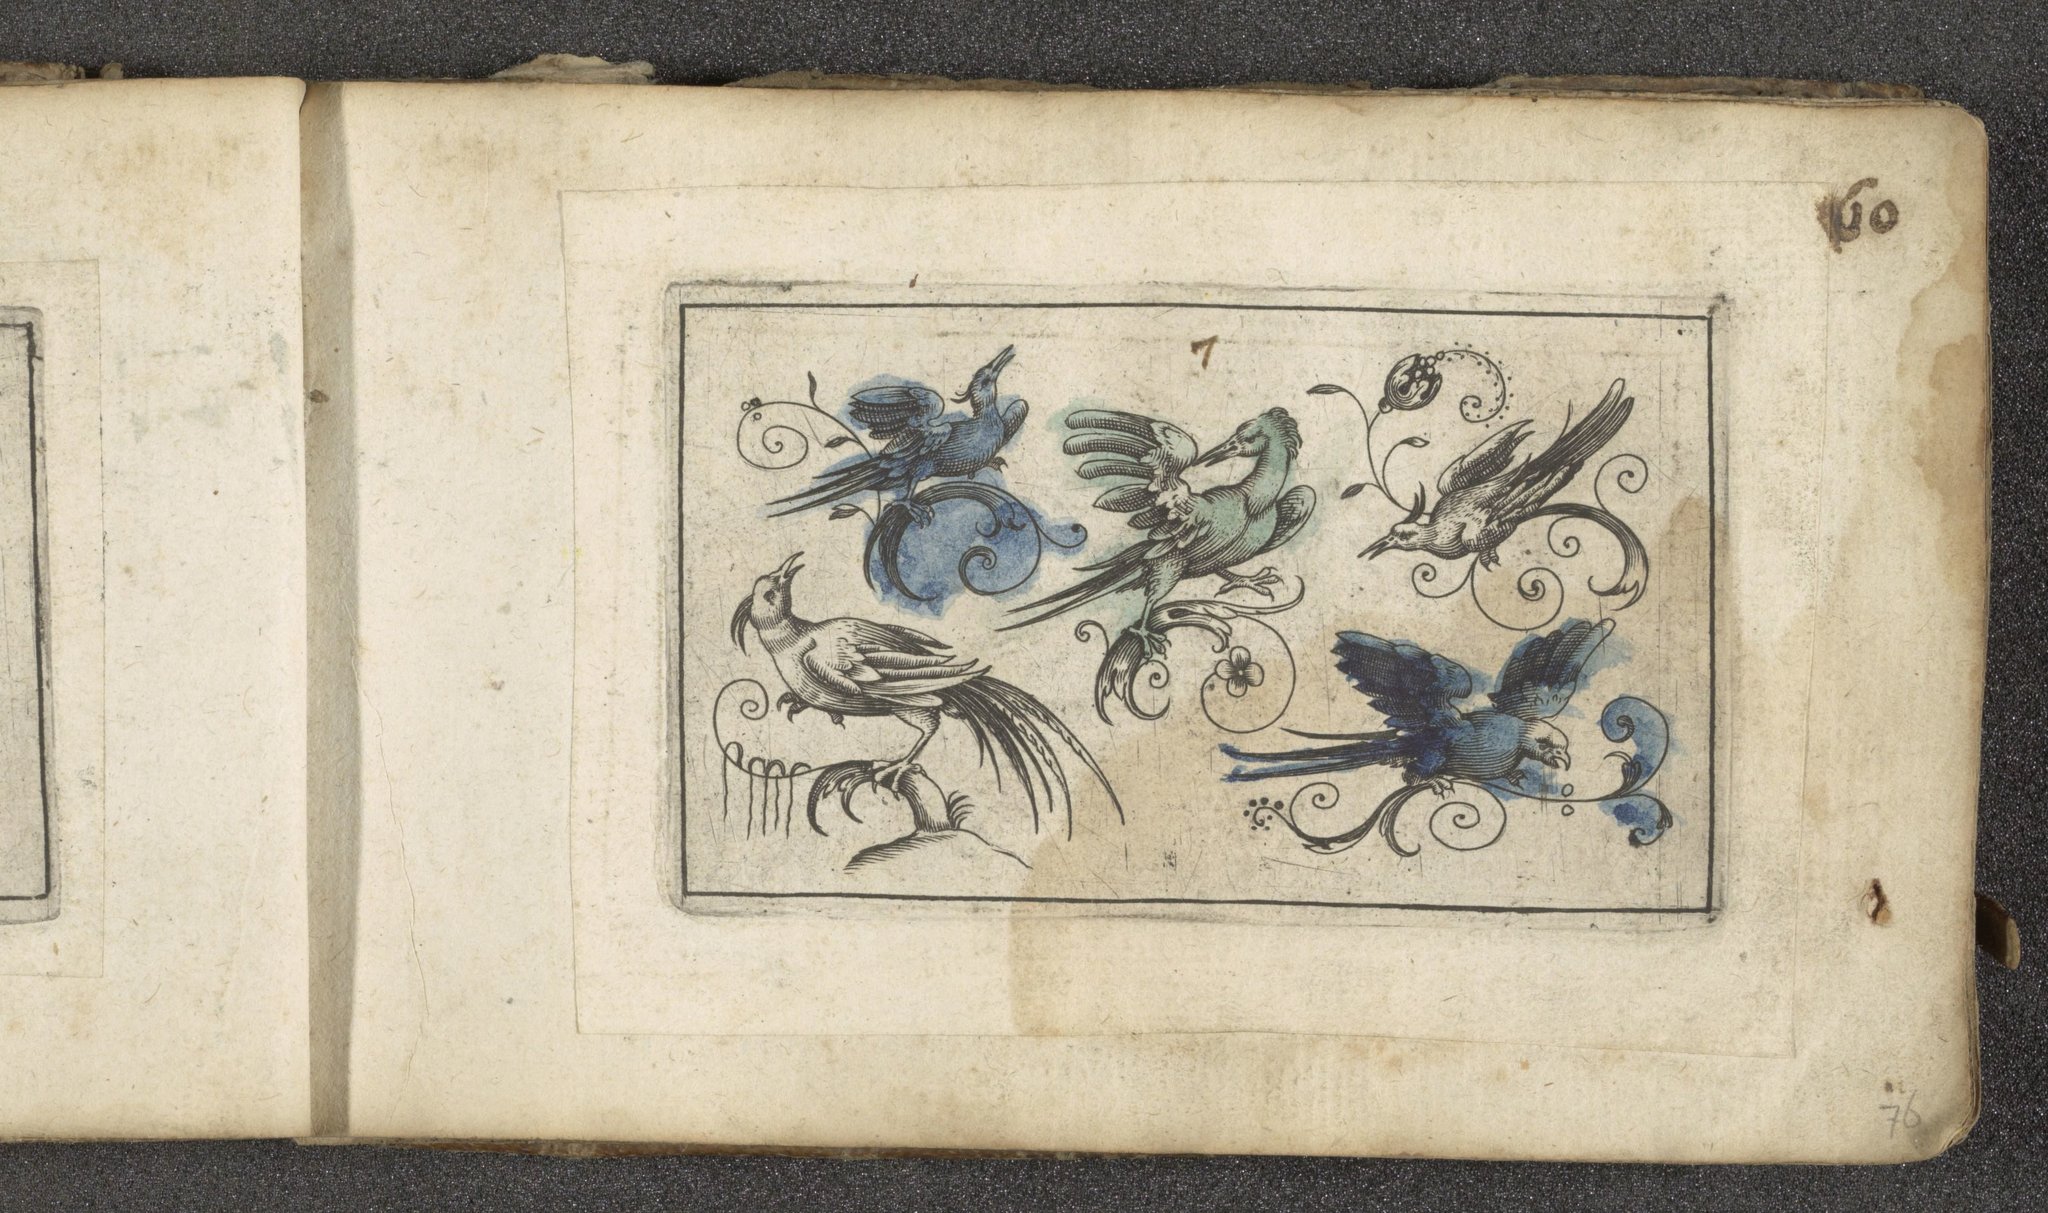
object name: album leaf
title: Vijf vogels op takken met ranken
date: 1601-1650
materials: paper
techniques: colour, engraving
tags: birds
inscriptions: inscription: ‘7’, inscription: ‘60’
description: Kopie in spiegelbeeld van een prent in de serie vogels van Adriaen Muntinck.